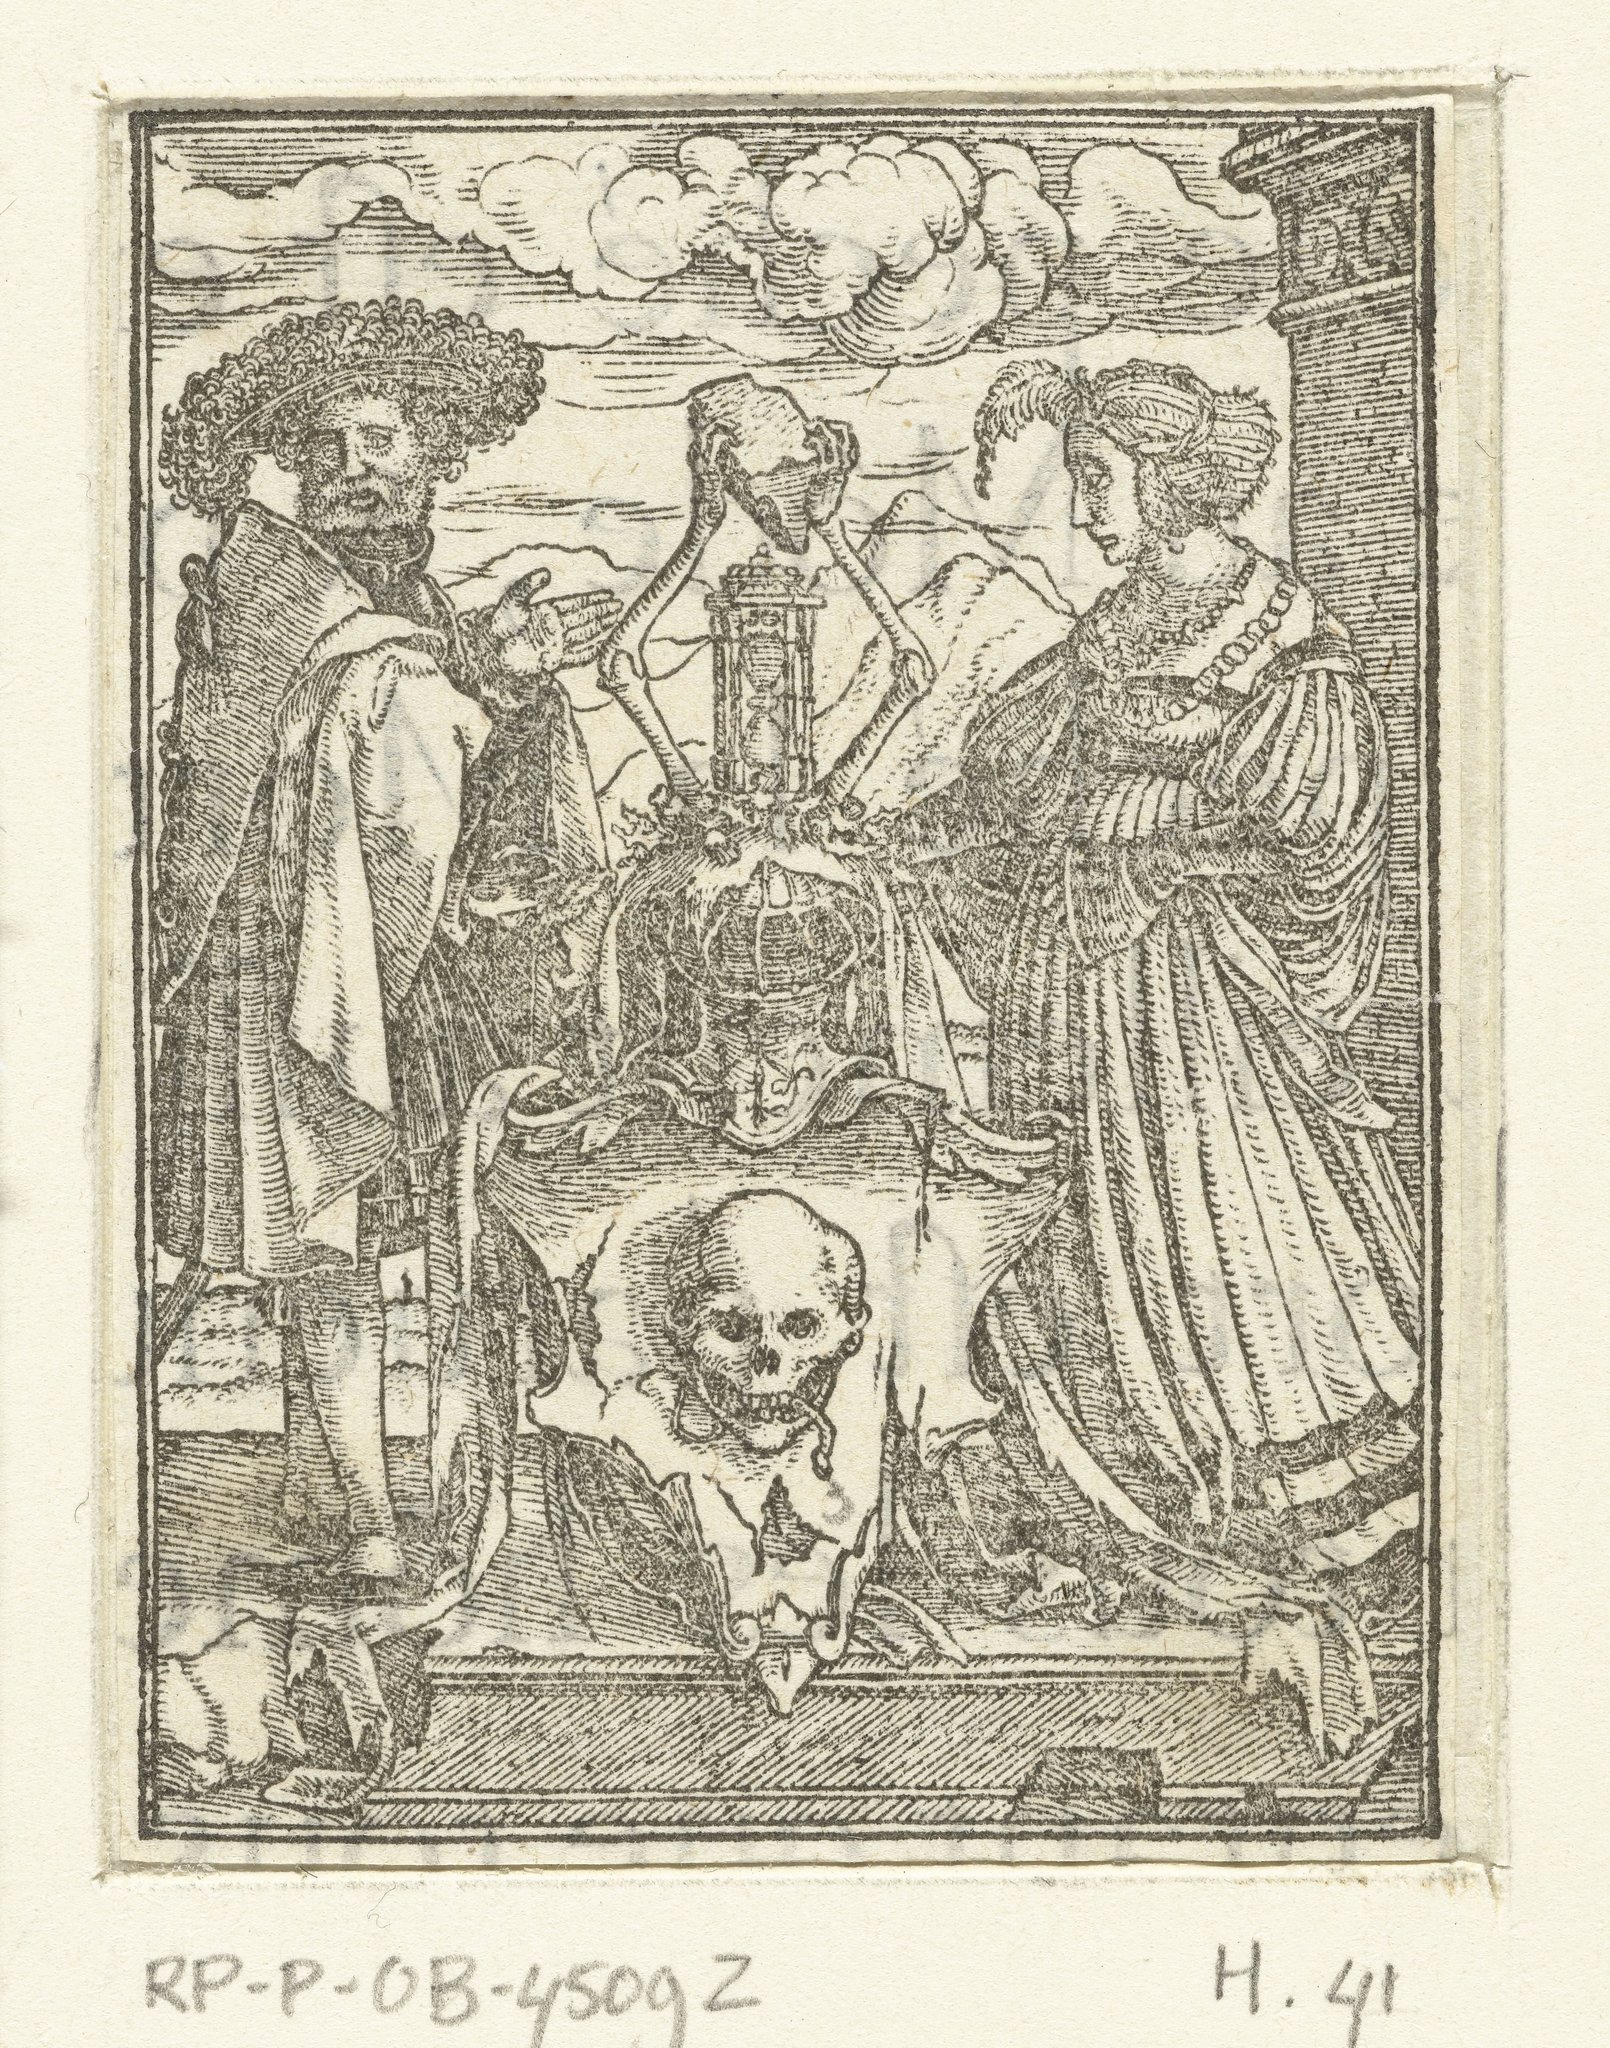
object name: book illustration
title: Dodendans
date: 1524-1526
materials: paper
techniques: woodcut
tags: coat of arms (symbol of sovereignty), dance of death; death together with one or more human beings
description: De houtblokken werden voor 1526 vervaardigd door Hans Lützelburg en pas in 1538 voor het eerst gebruikt als boekillustraties in: Les simulachres & historiees faces de la mort avtant elegamment pourtraictes que artificiellement imaginées... a Lyon, Soubsz l'escu de Coloigne, MDXXXVIII, (M. en G. Trechsel, voor F. Frellon in Lyon), 1538. Later verschenen nog andere uitgaven.